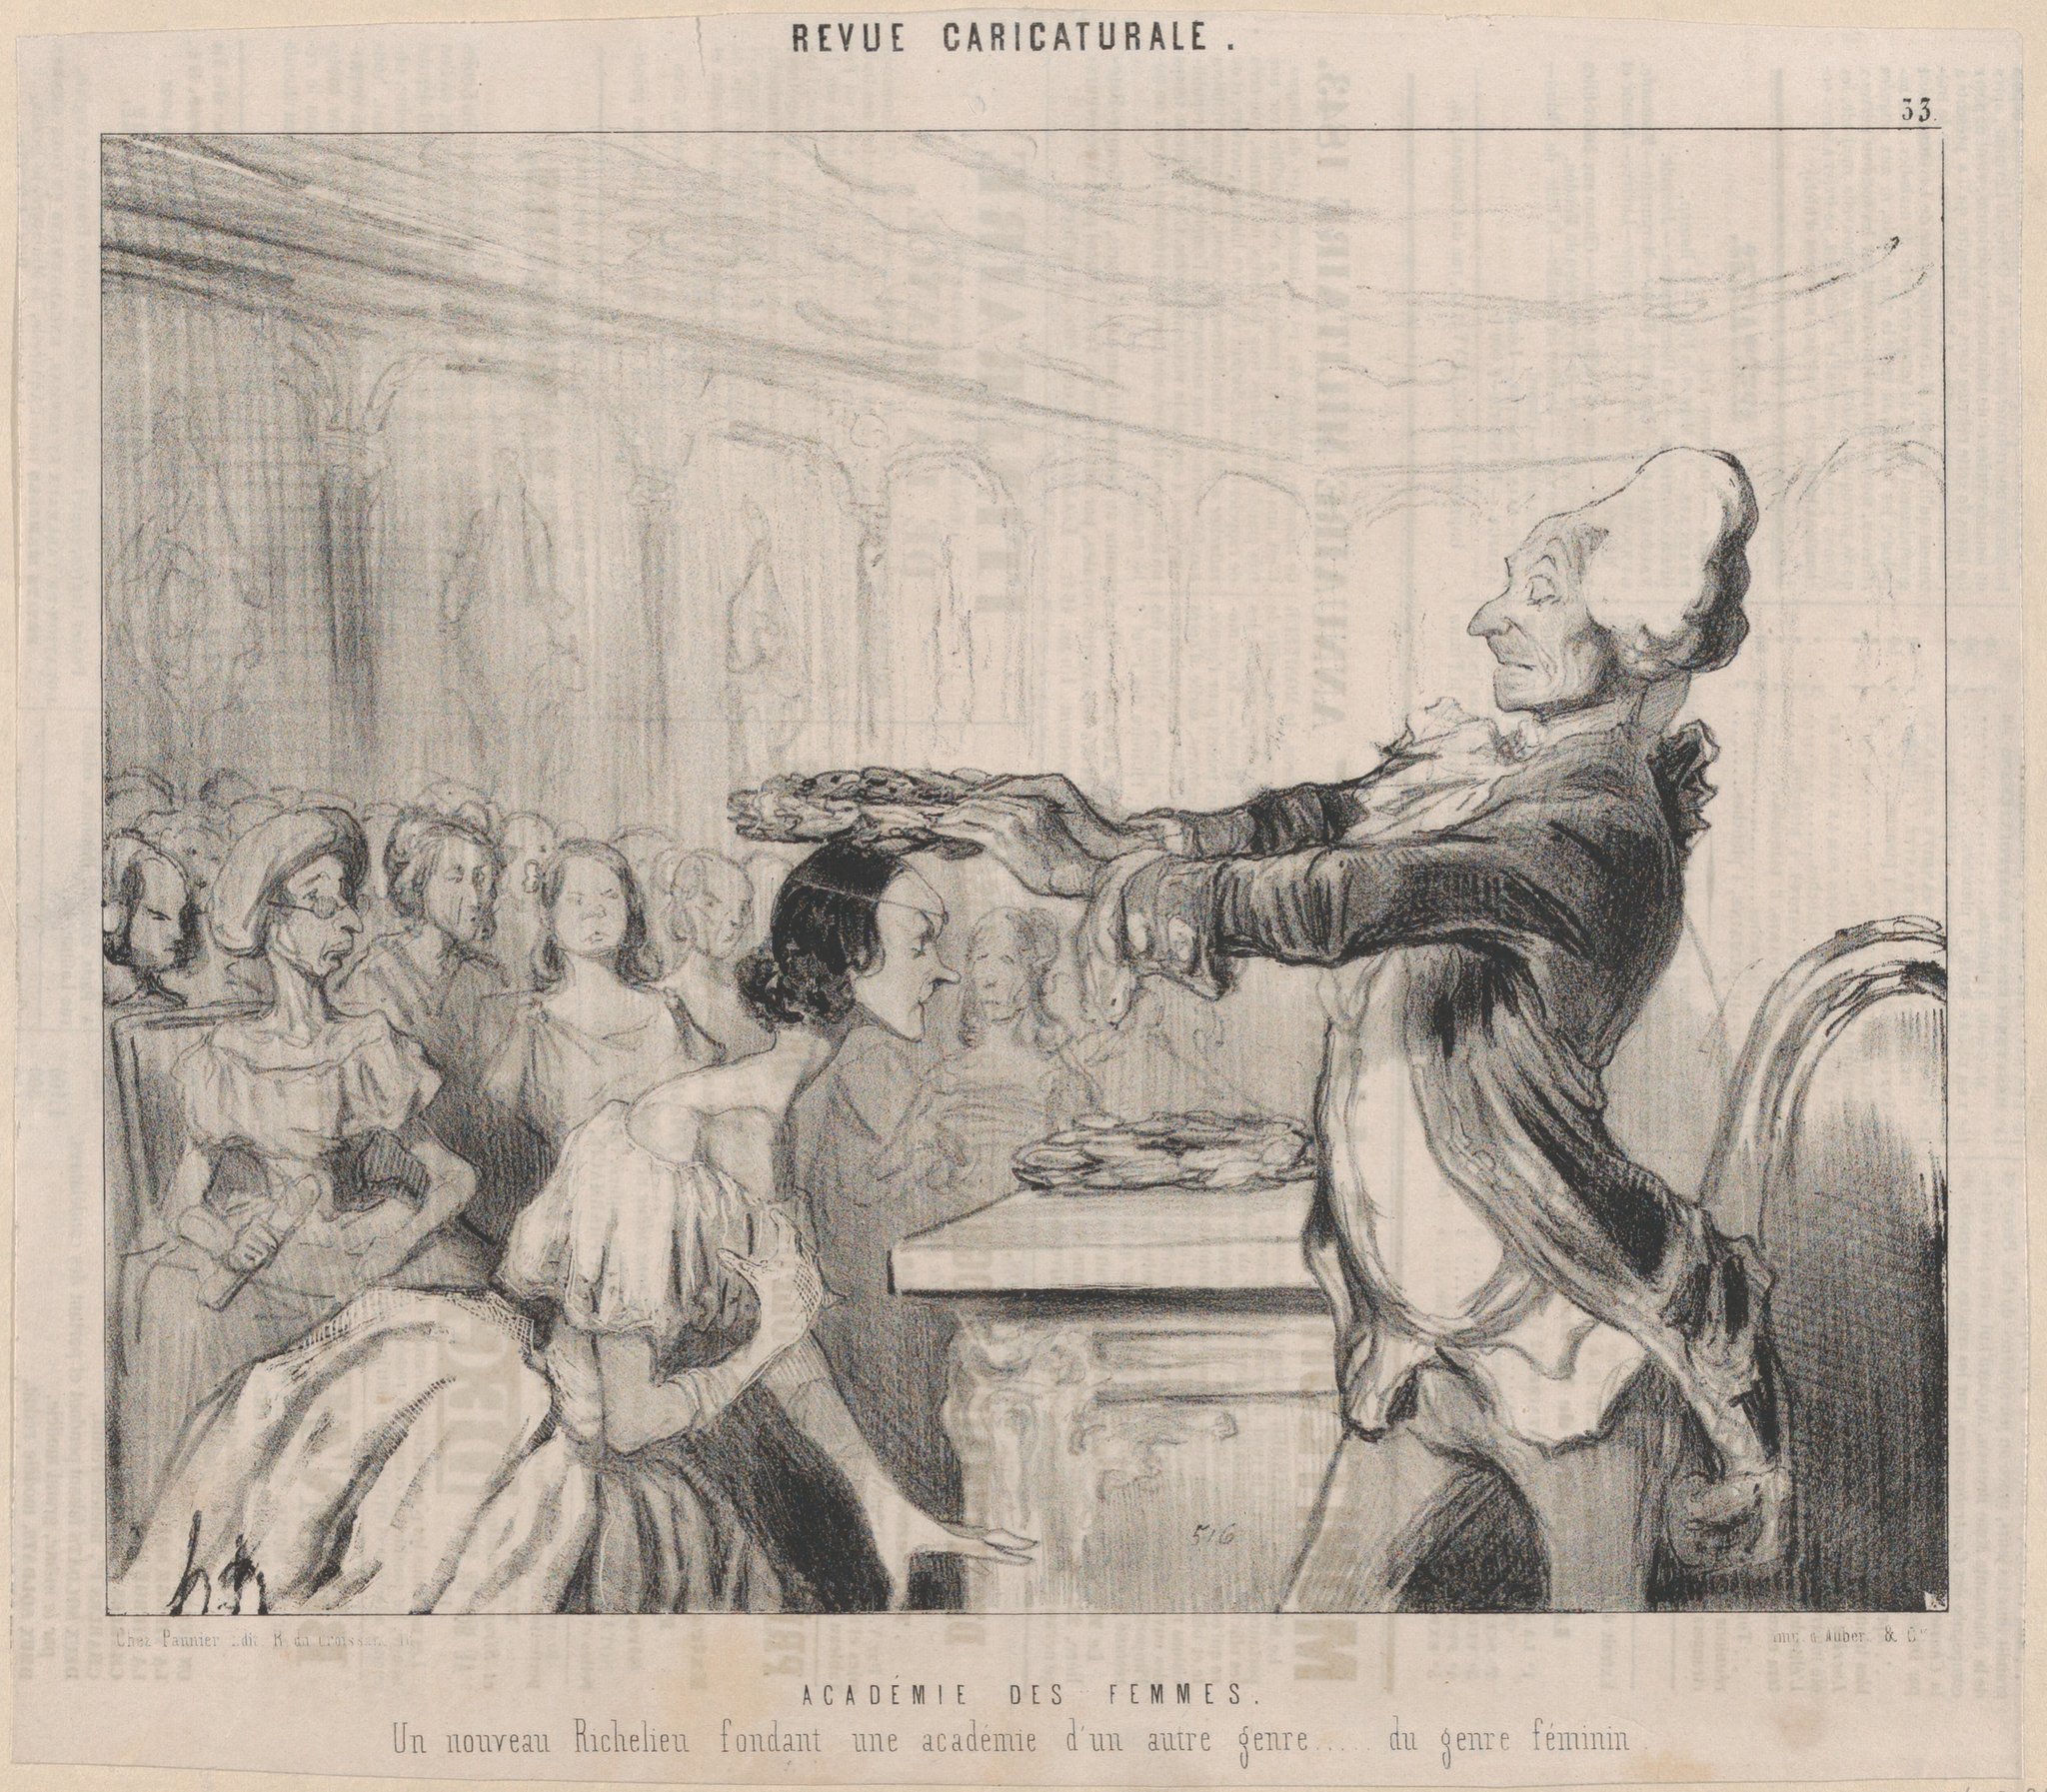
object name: print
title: Academy of Women, from "Le Charivari"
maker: honoré daumier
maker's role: artist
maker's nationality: french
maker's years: 1808-1879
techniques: lithograph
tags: men,women,caricature